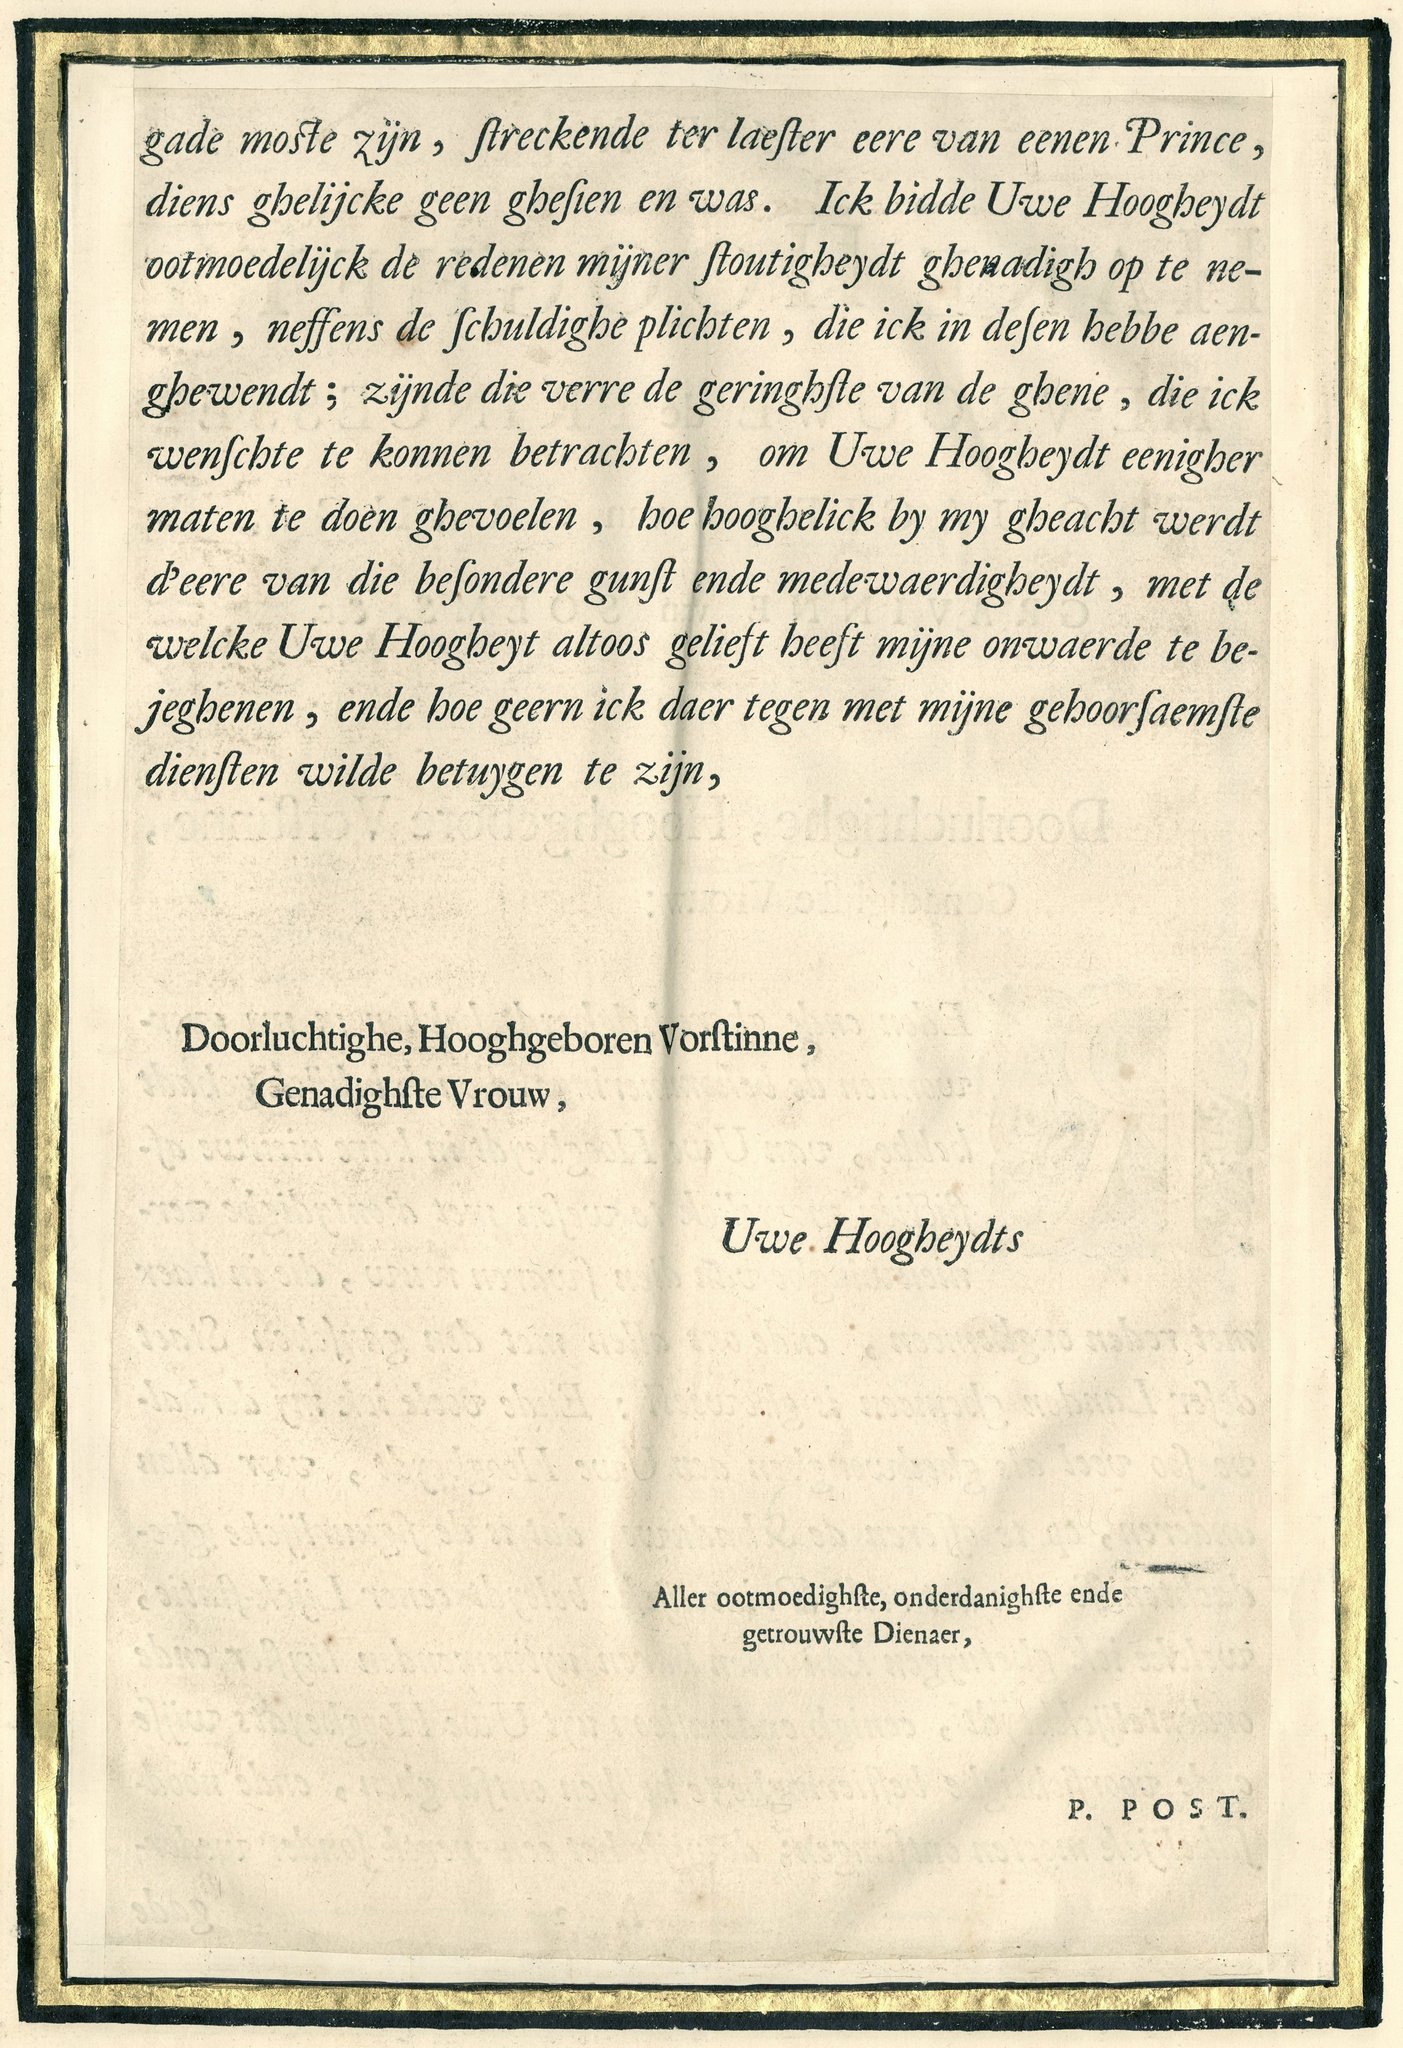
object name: text sheet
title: Begraeffenisse van syne hoogheyt Frederick Henrick. Luxe ingekleurde uitgave van de prenten van de begrafenisstoet van Frederik Hendrik in 1647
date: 1651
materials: paint, paper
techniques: letterpress printing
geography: amsterdam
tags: frederick henry (prince of orange), amalia of solms-braunfels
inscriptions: date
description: De opdracht (achterzijde) aan Amalia van Solms, de weduwe van Frederik Hendrik. Blad uitgeknipt, versierd met goud en ingeplakt in de luxe editie uit ca. 1755 van het boek 'Begraeffenisse van syne hoogheyt Frederick Henrick' van Pieter Post, uitgegeven te Amsterdam in 1651.